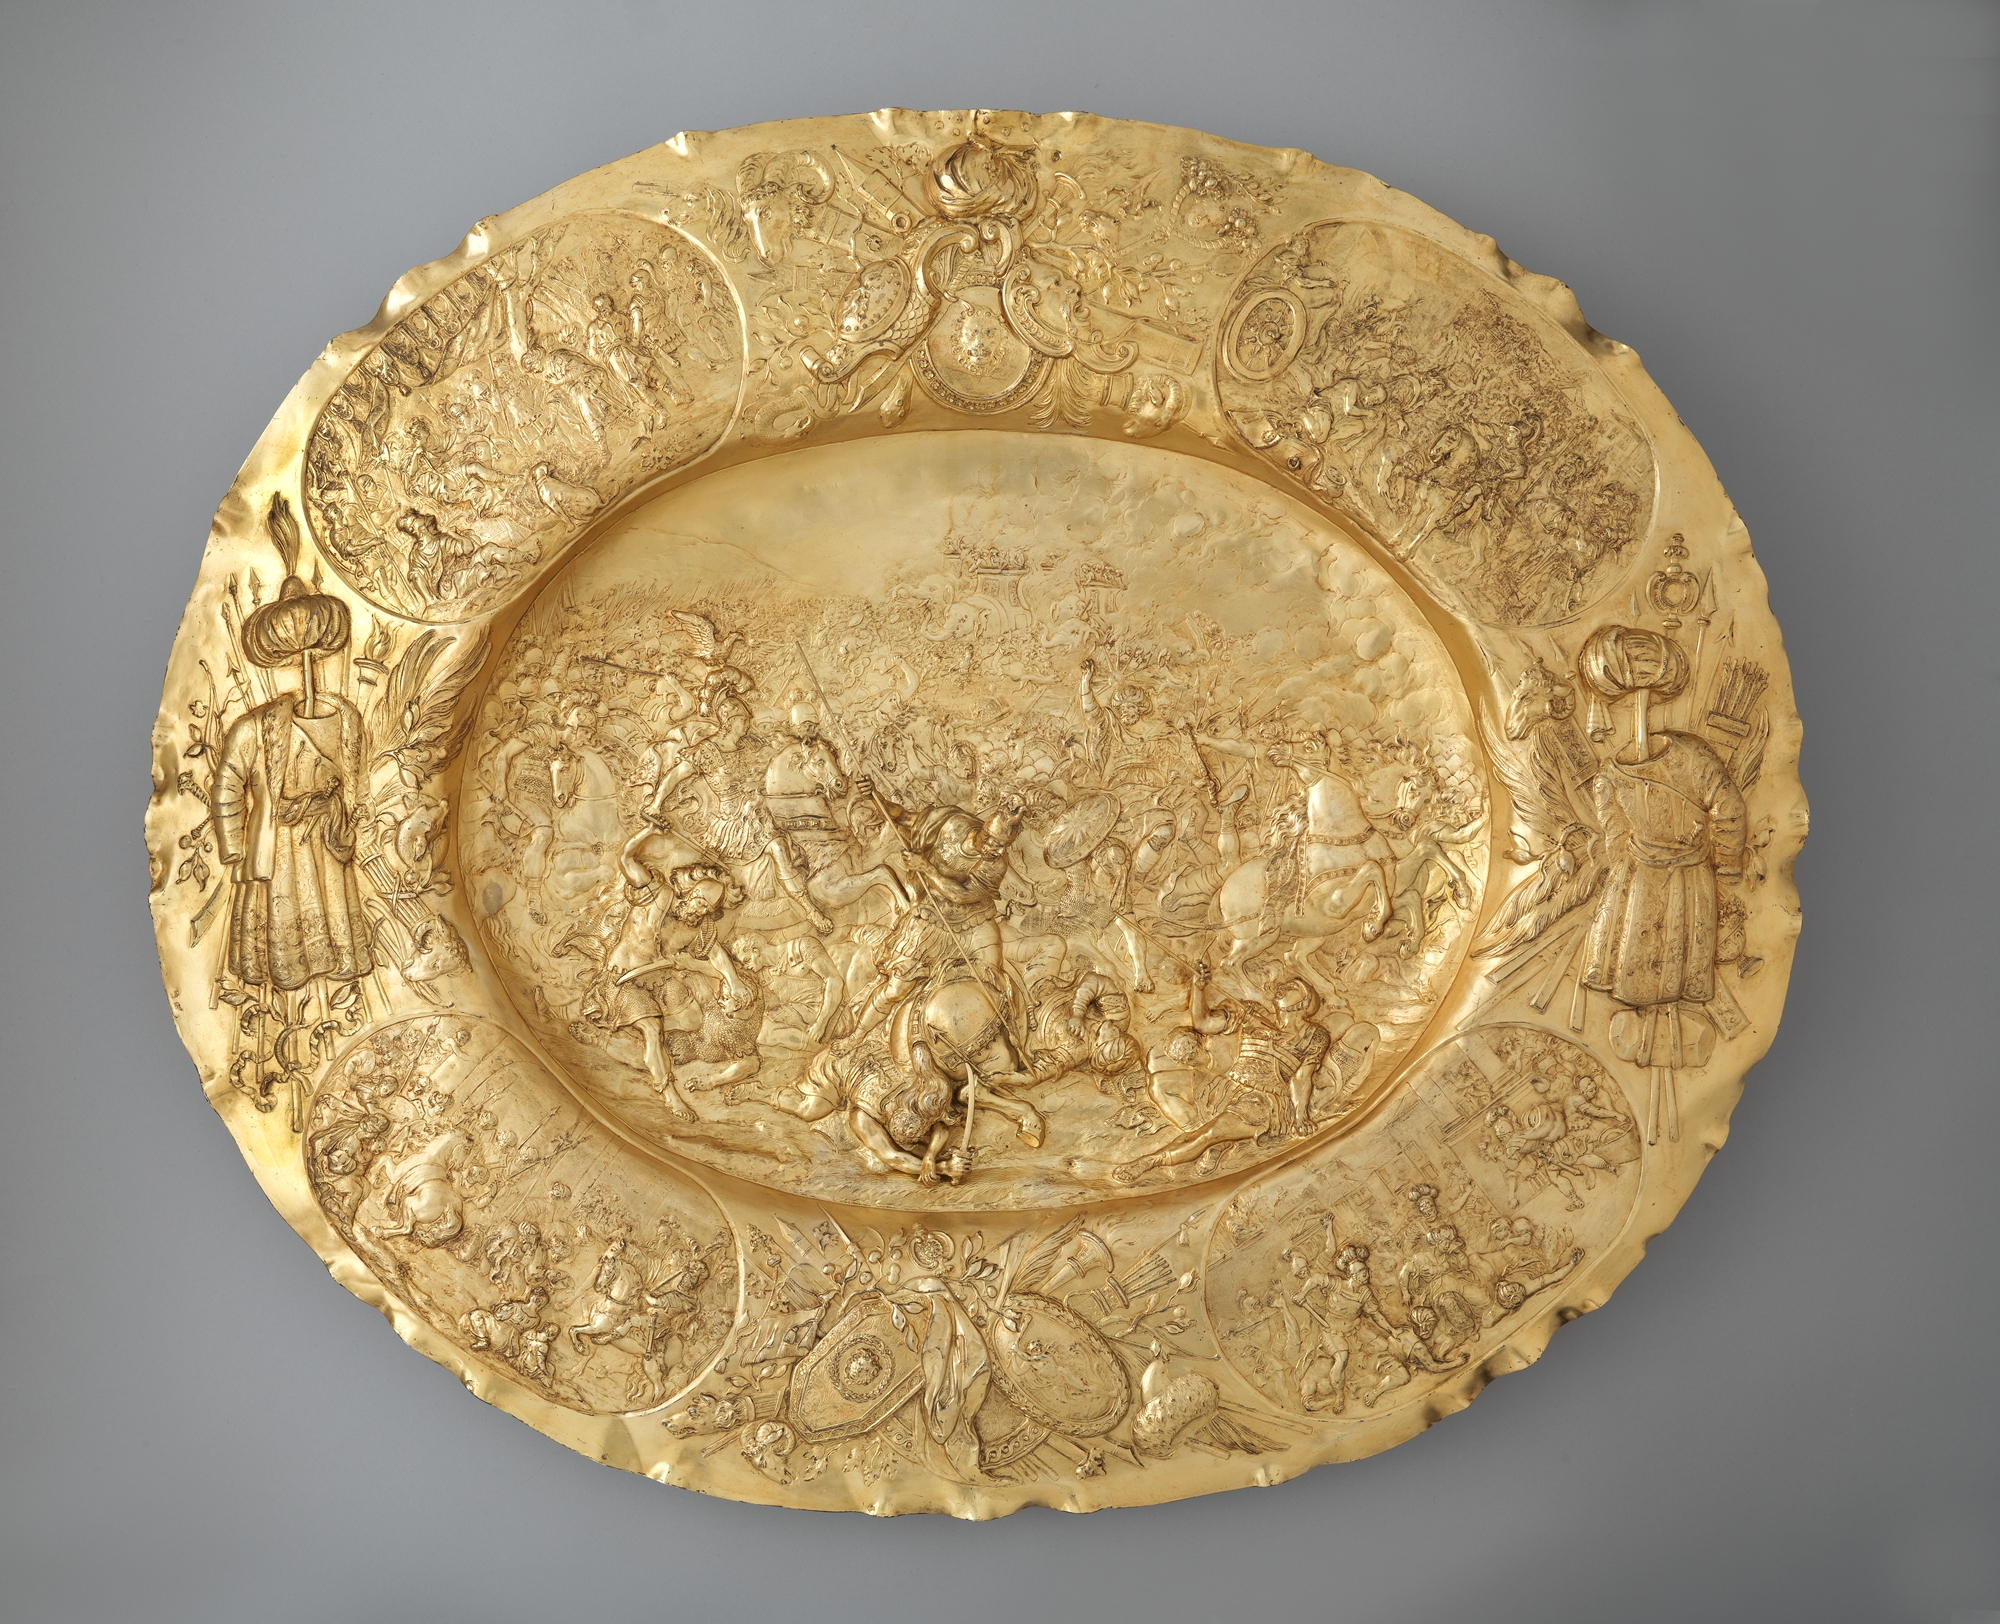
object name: plateau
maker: elkington & co.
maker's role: manufacturer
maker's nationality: british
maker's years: 1829-1963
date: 1801-1900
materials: copper, gilt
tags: battles,soldiers,elephants,horses